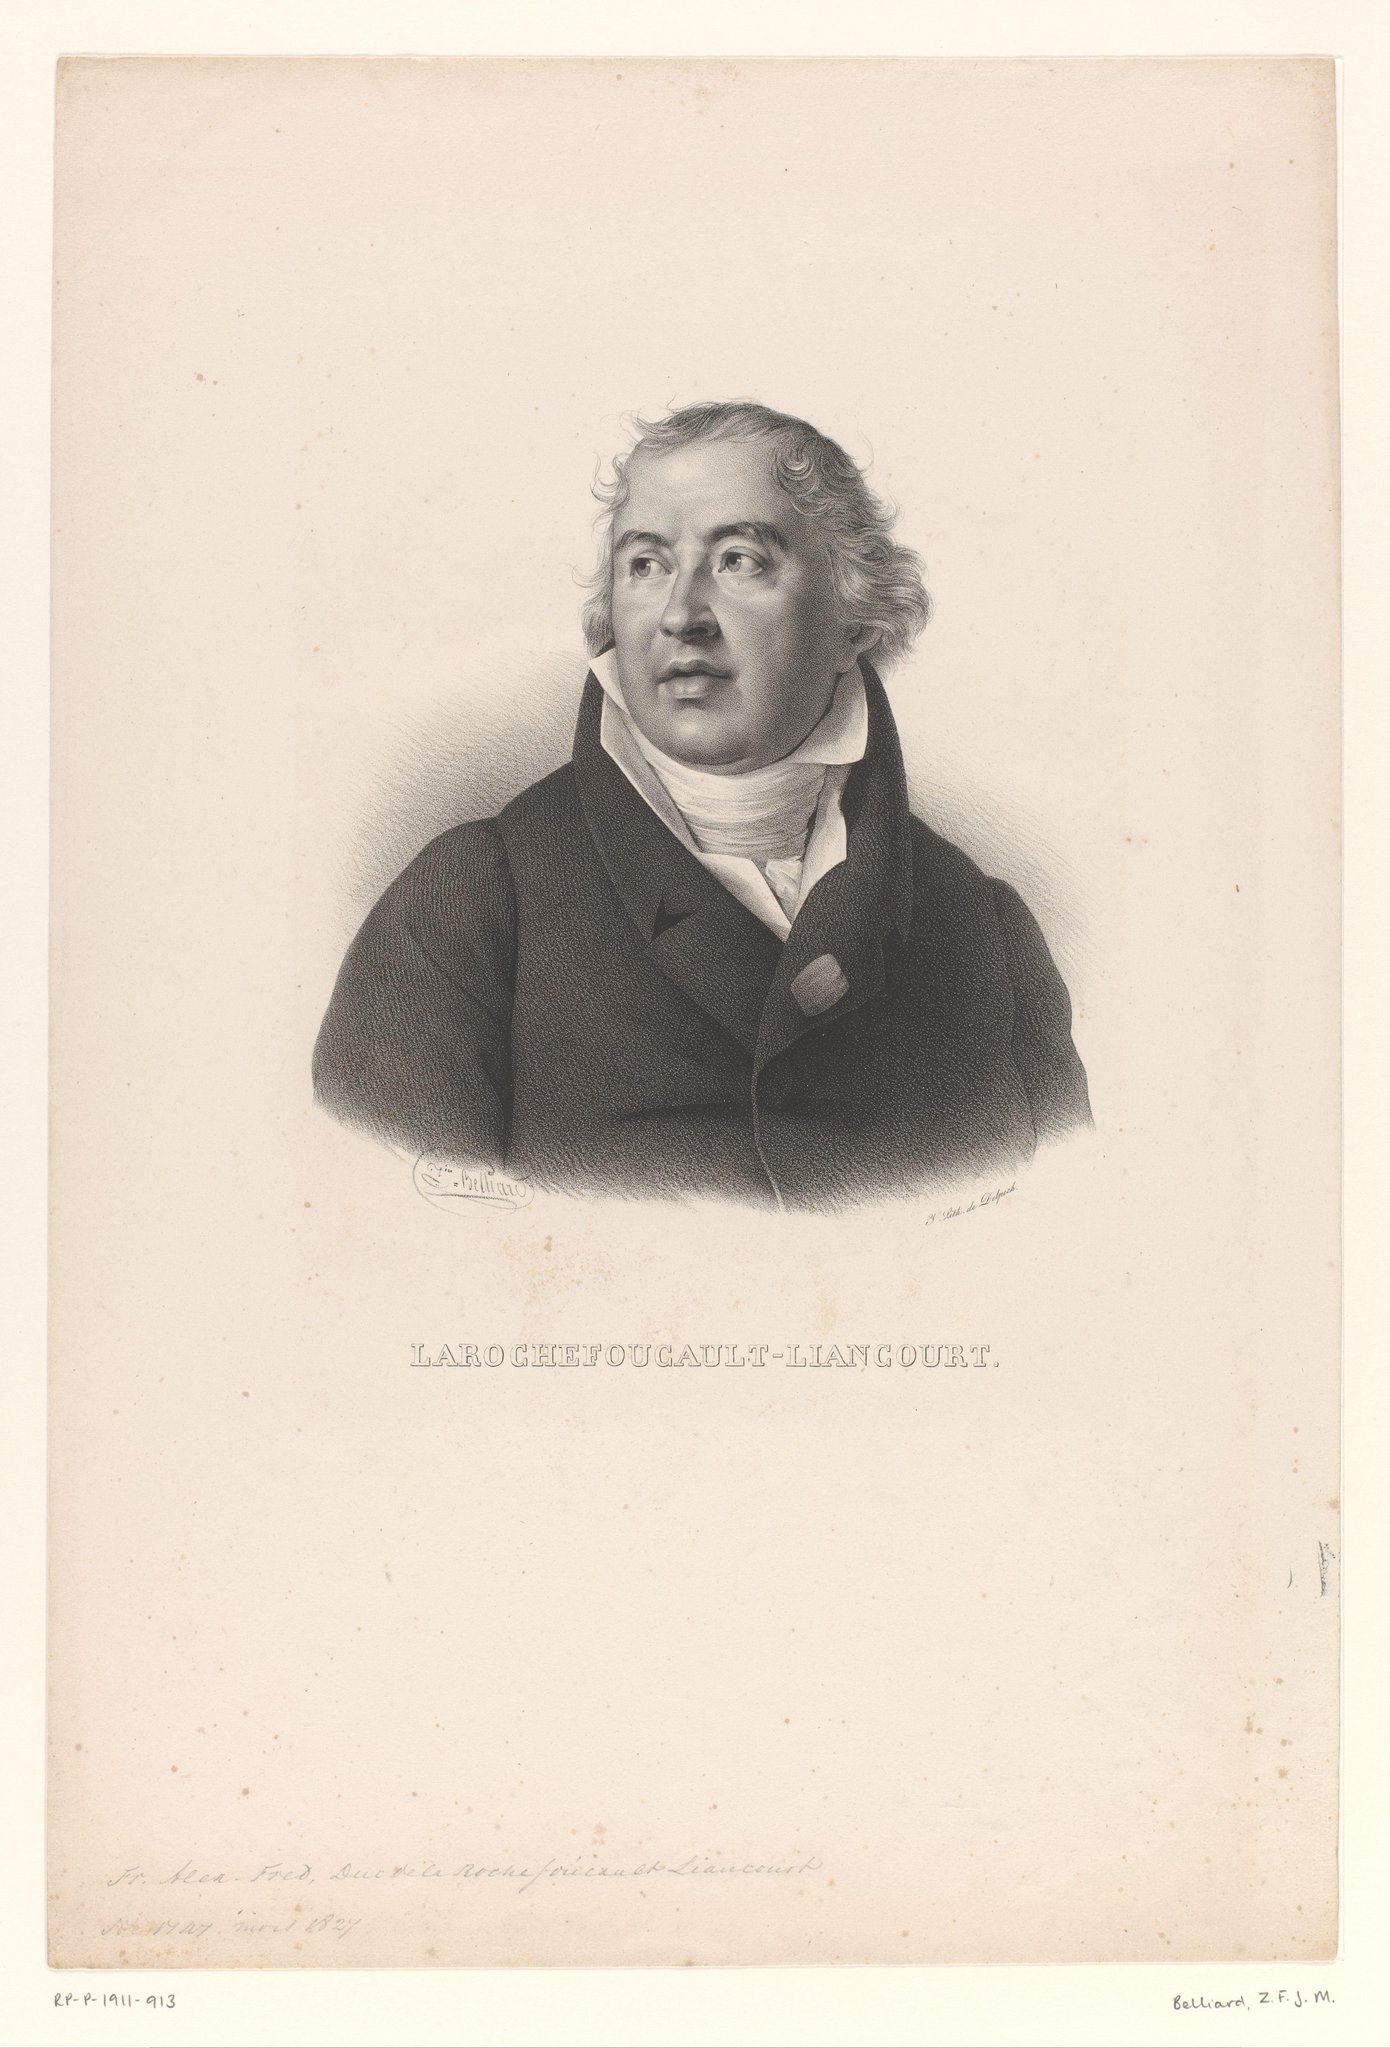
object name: book illustration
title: Larochefoucault-Liancourt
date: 1827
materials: paper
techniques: lithograph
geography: paris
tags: paris, politician, historical persons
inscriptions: collector's mark: Lugt 2228a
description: Prent gepubliceerd in: Iconographie des contemporaines ou portraits des personnes depuis 1789, jusqu'en 1829, Delpech, Parijs 1832.